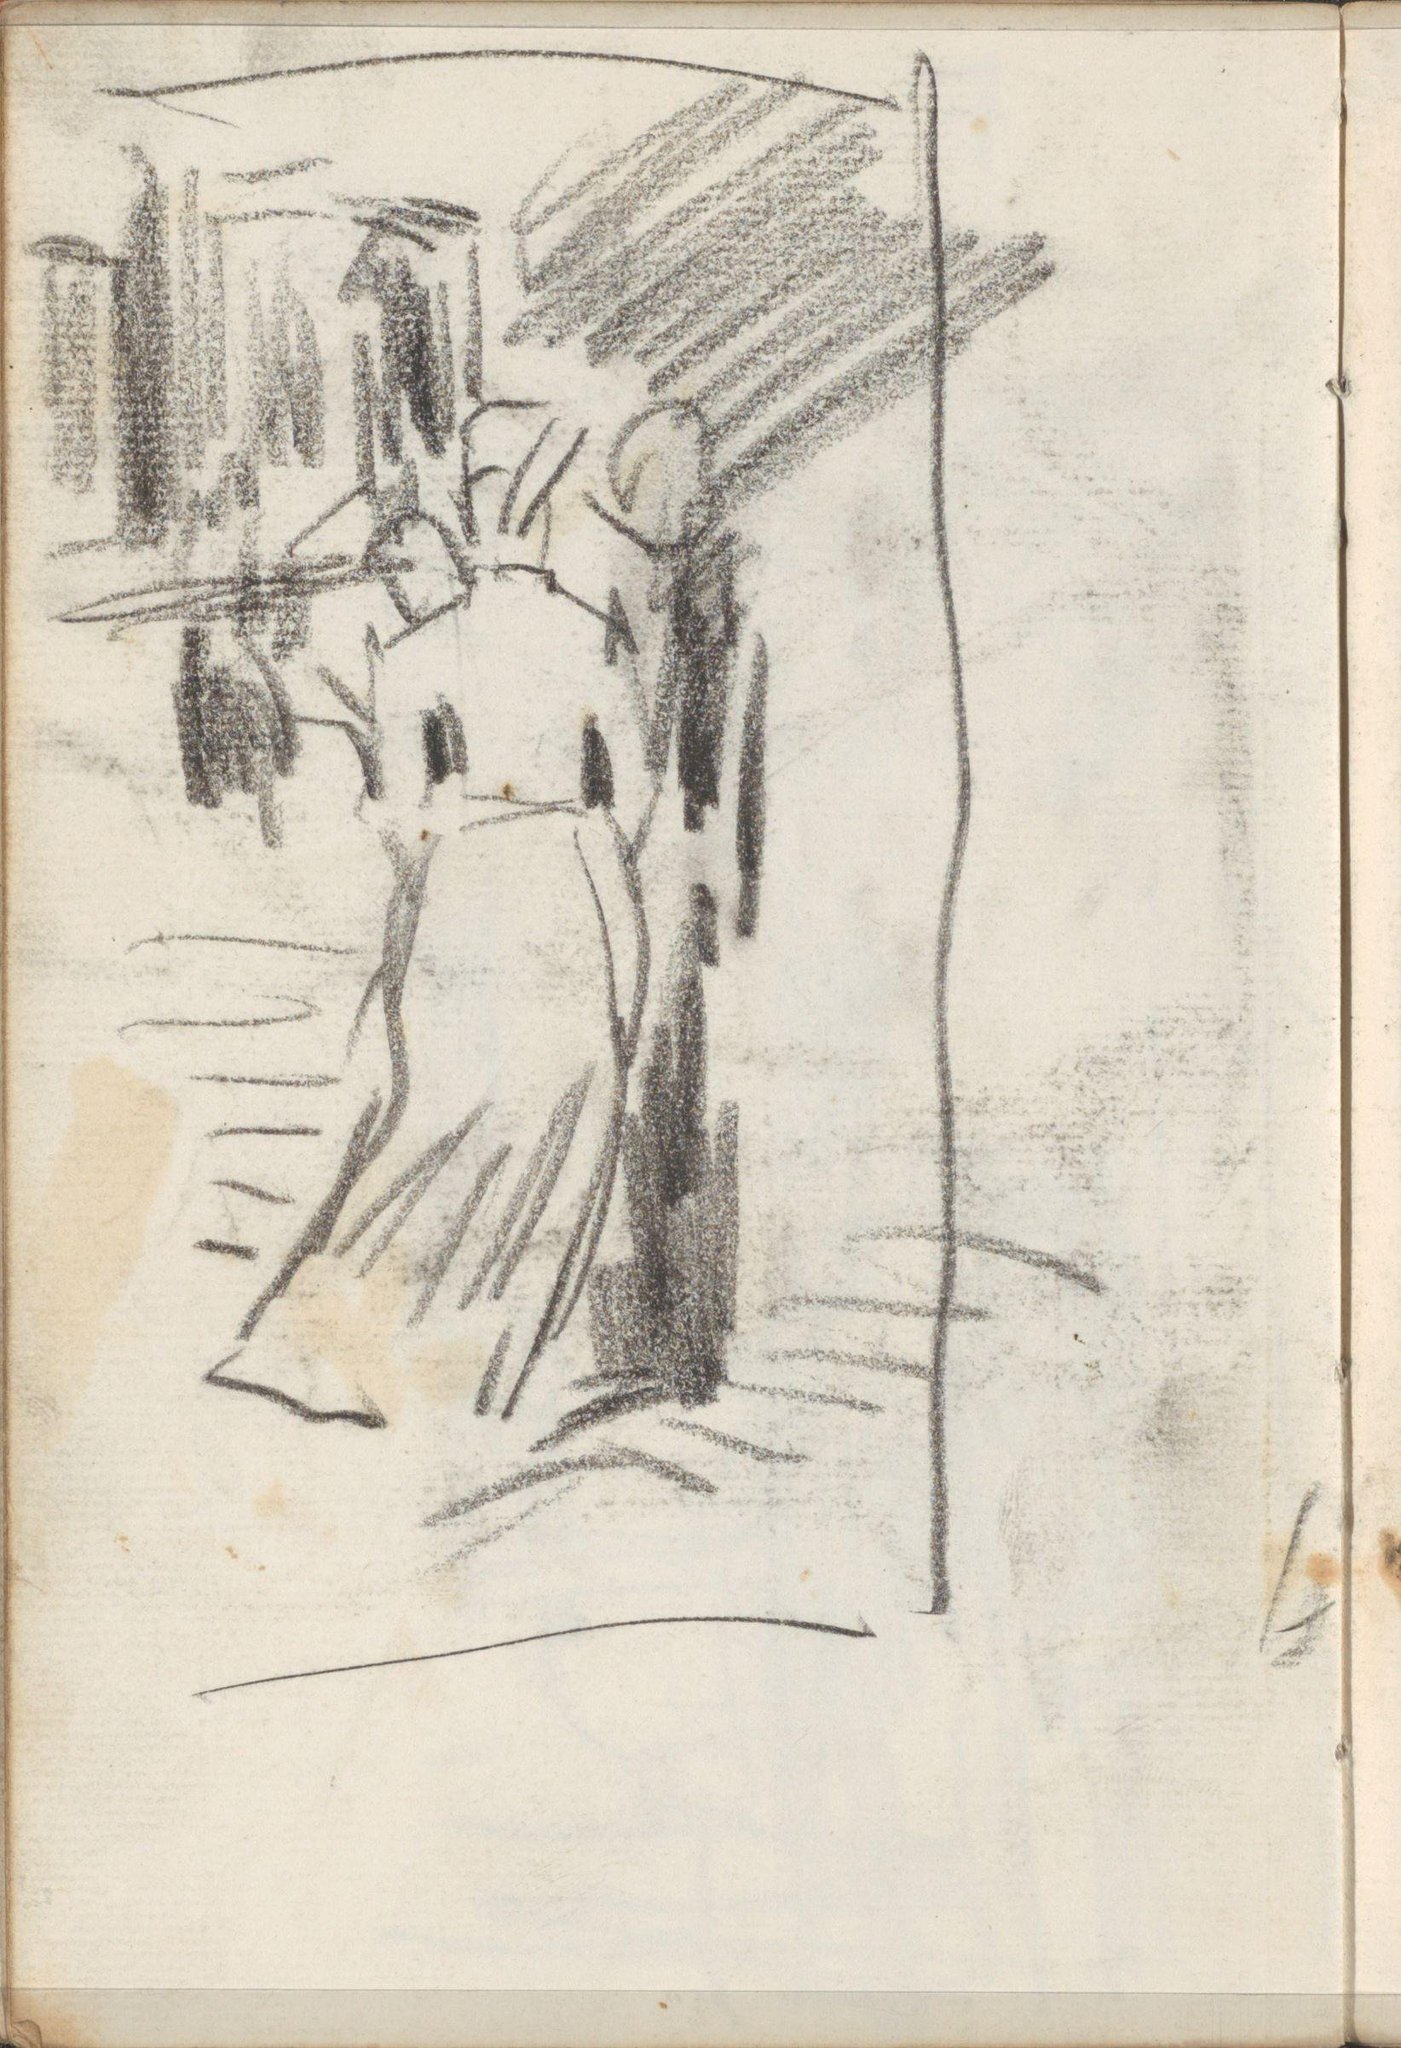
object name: sketchbook leaf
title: Figuren op straat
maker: george hendrik breitner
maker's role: draughtsman, painter, print maker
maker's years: 1857-1923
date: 1886-1898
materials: chalk, paper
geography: amsterdam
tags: adult woman, street (+ city(-scape) with figures, staffage), amsterdam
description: Mogelijk vrouwen. Pagina 21 uit een schetsboek met 21 bladen.